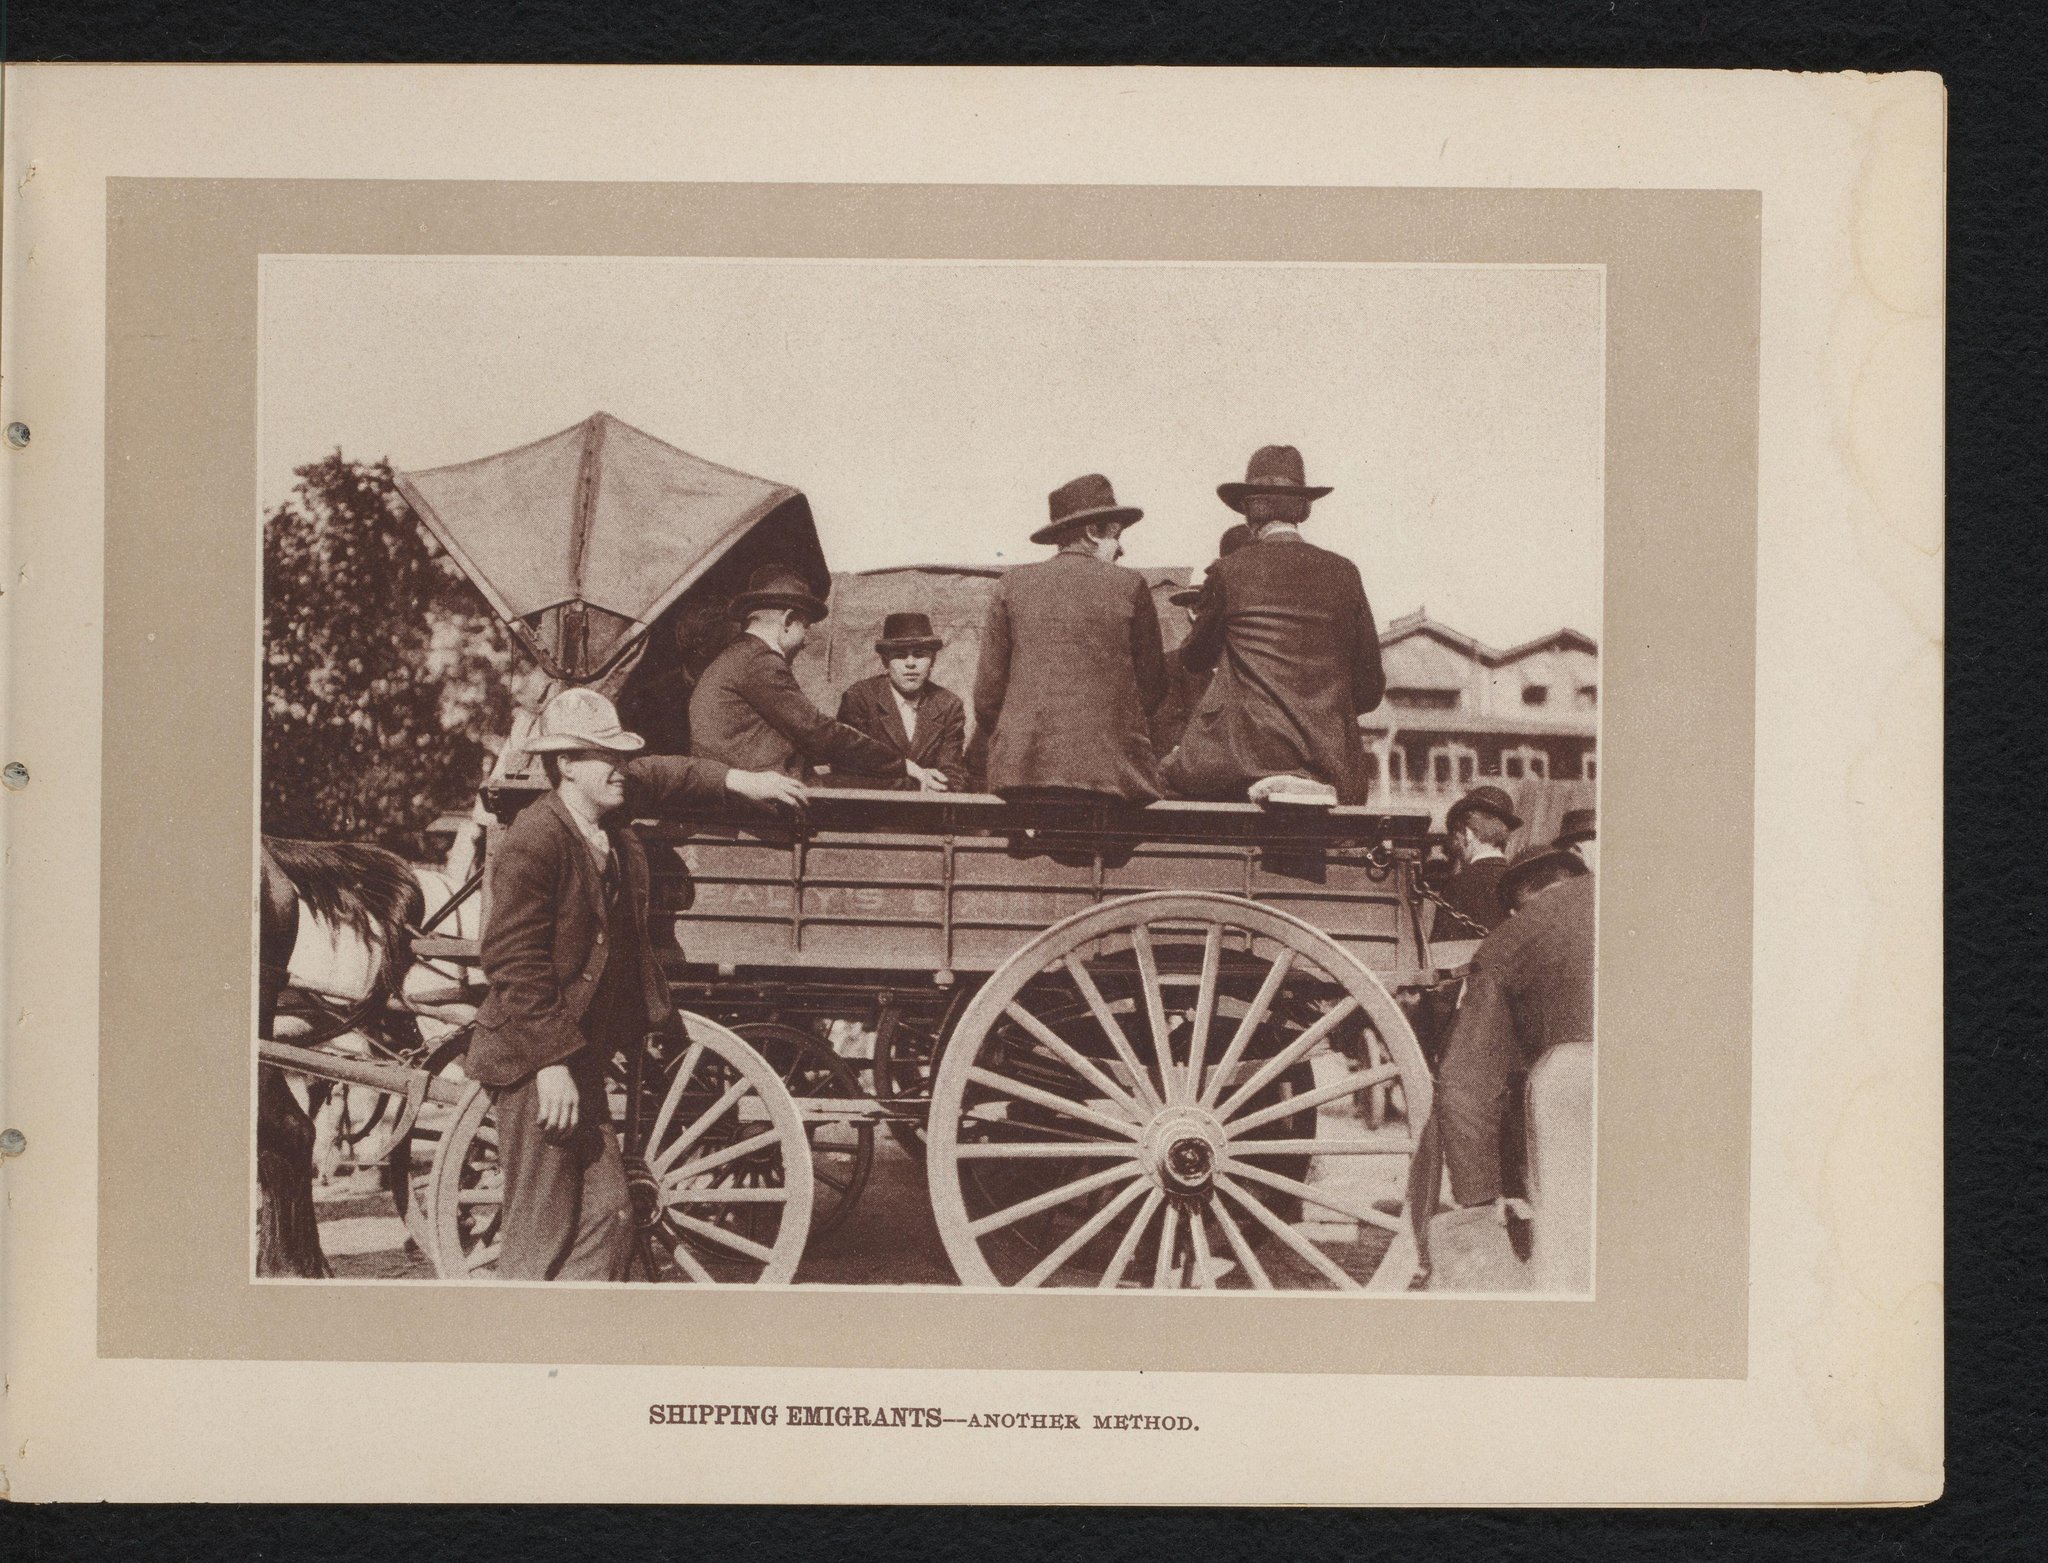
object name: page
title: Migranten in een rijtuig op doorreis vanuit de aankomsthaven in New York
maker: Anonymous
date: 1897-1902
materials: paper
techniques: autotype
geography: new york city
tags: animal traction, animal-drawn vehicle (carriage etc.), (descendants of) european emigrants to america, historical persons not known by name, new york (city)